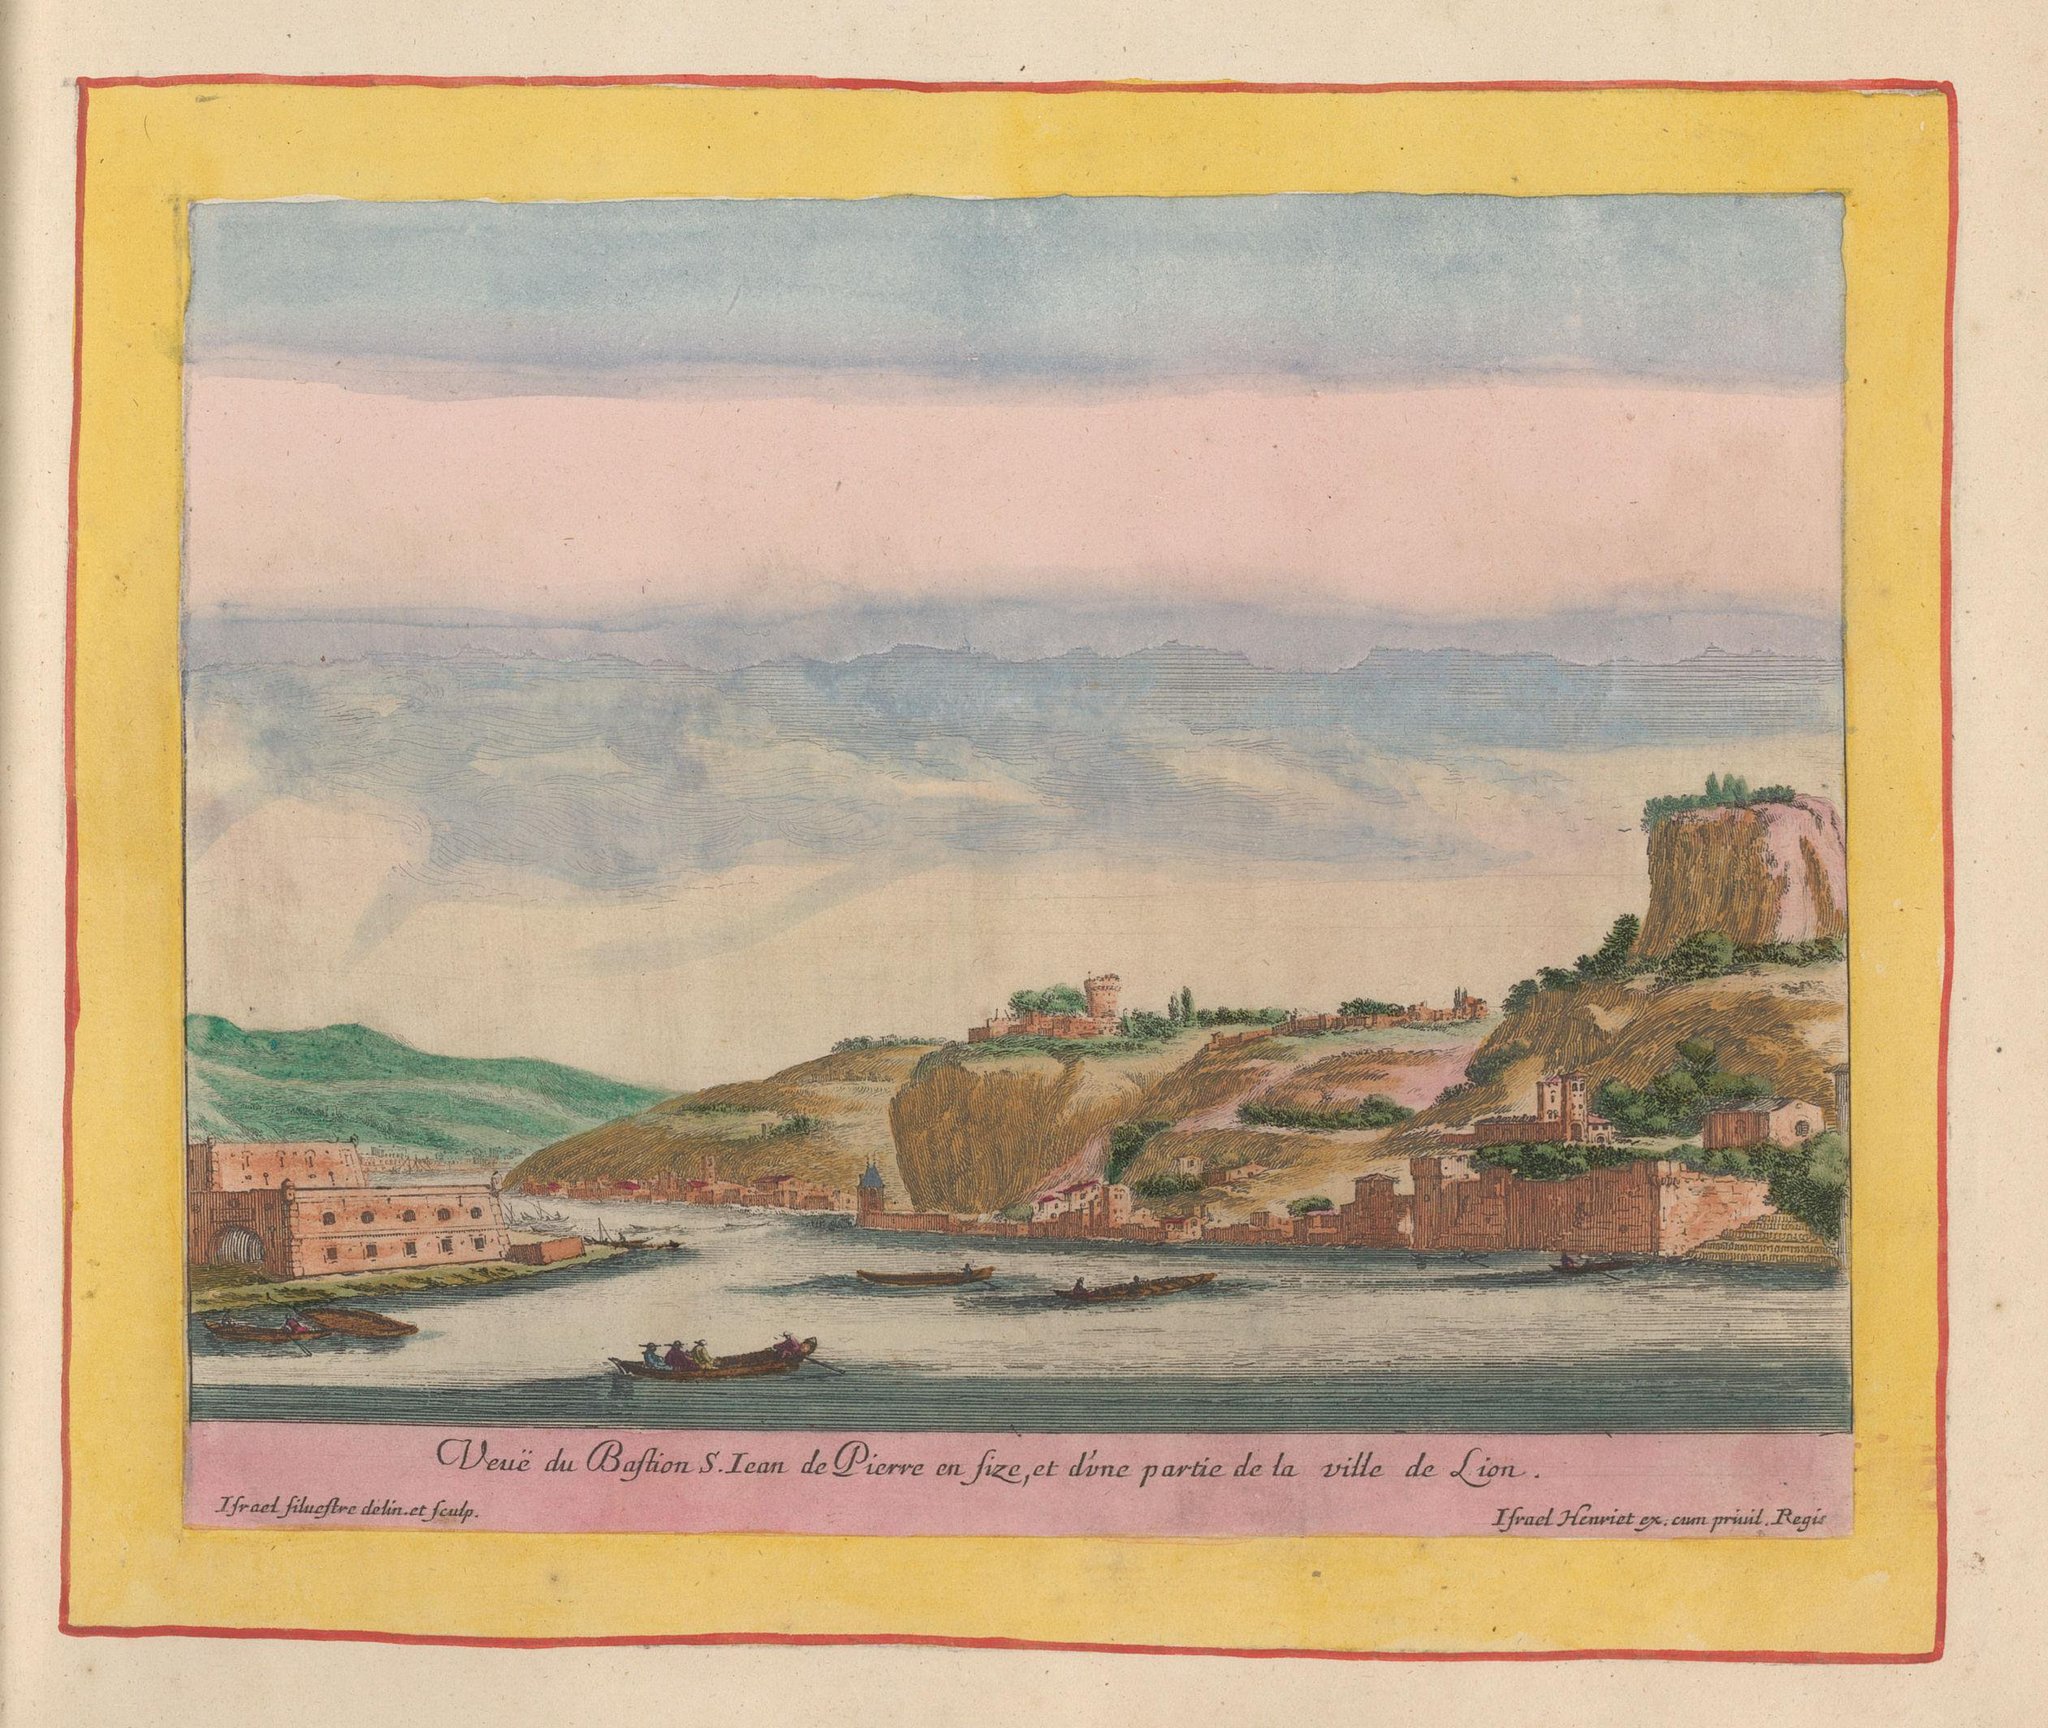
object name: print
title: Veuë du bastion S. Jean de Pierre en size, et d'une partie de la ville de Lion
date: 1631-1661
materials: paper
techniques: etching, hand coloring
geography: the hague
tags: city-view in general; 'veduta', lyon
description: Deze prent maakt deel uit van een album.